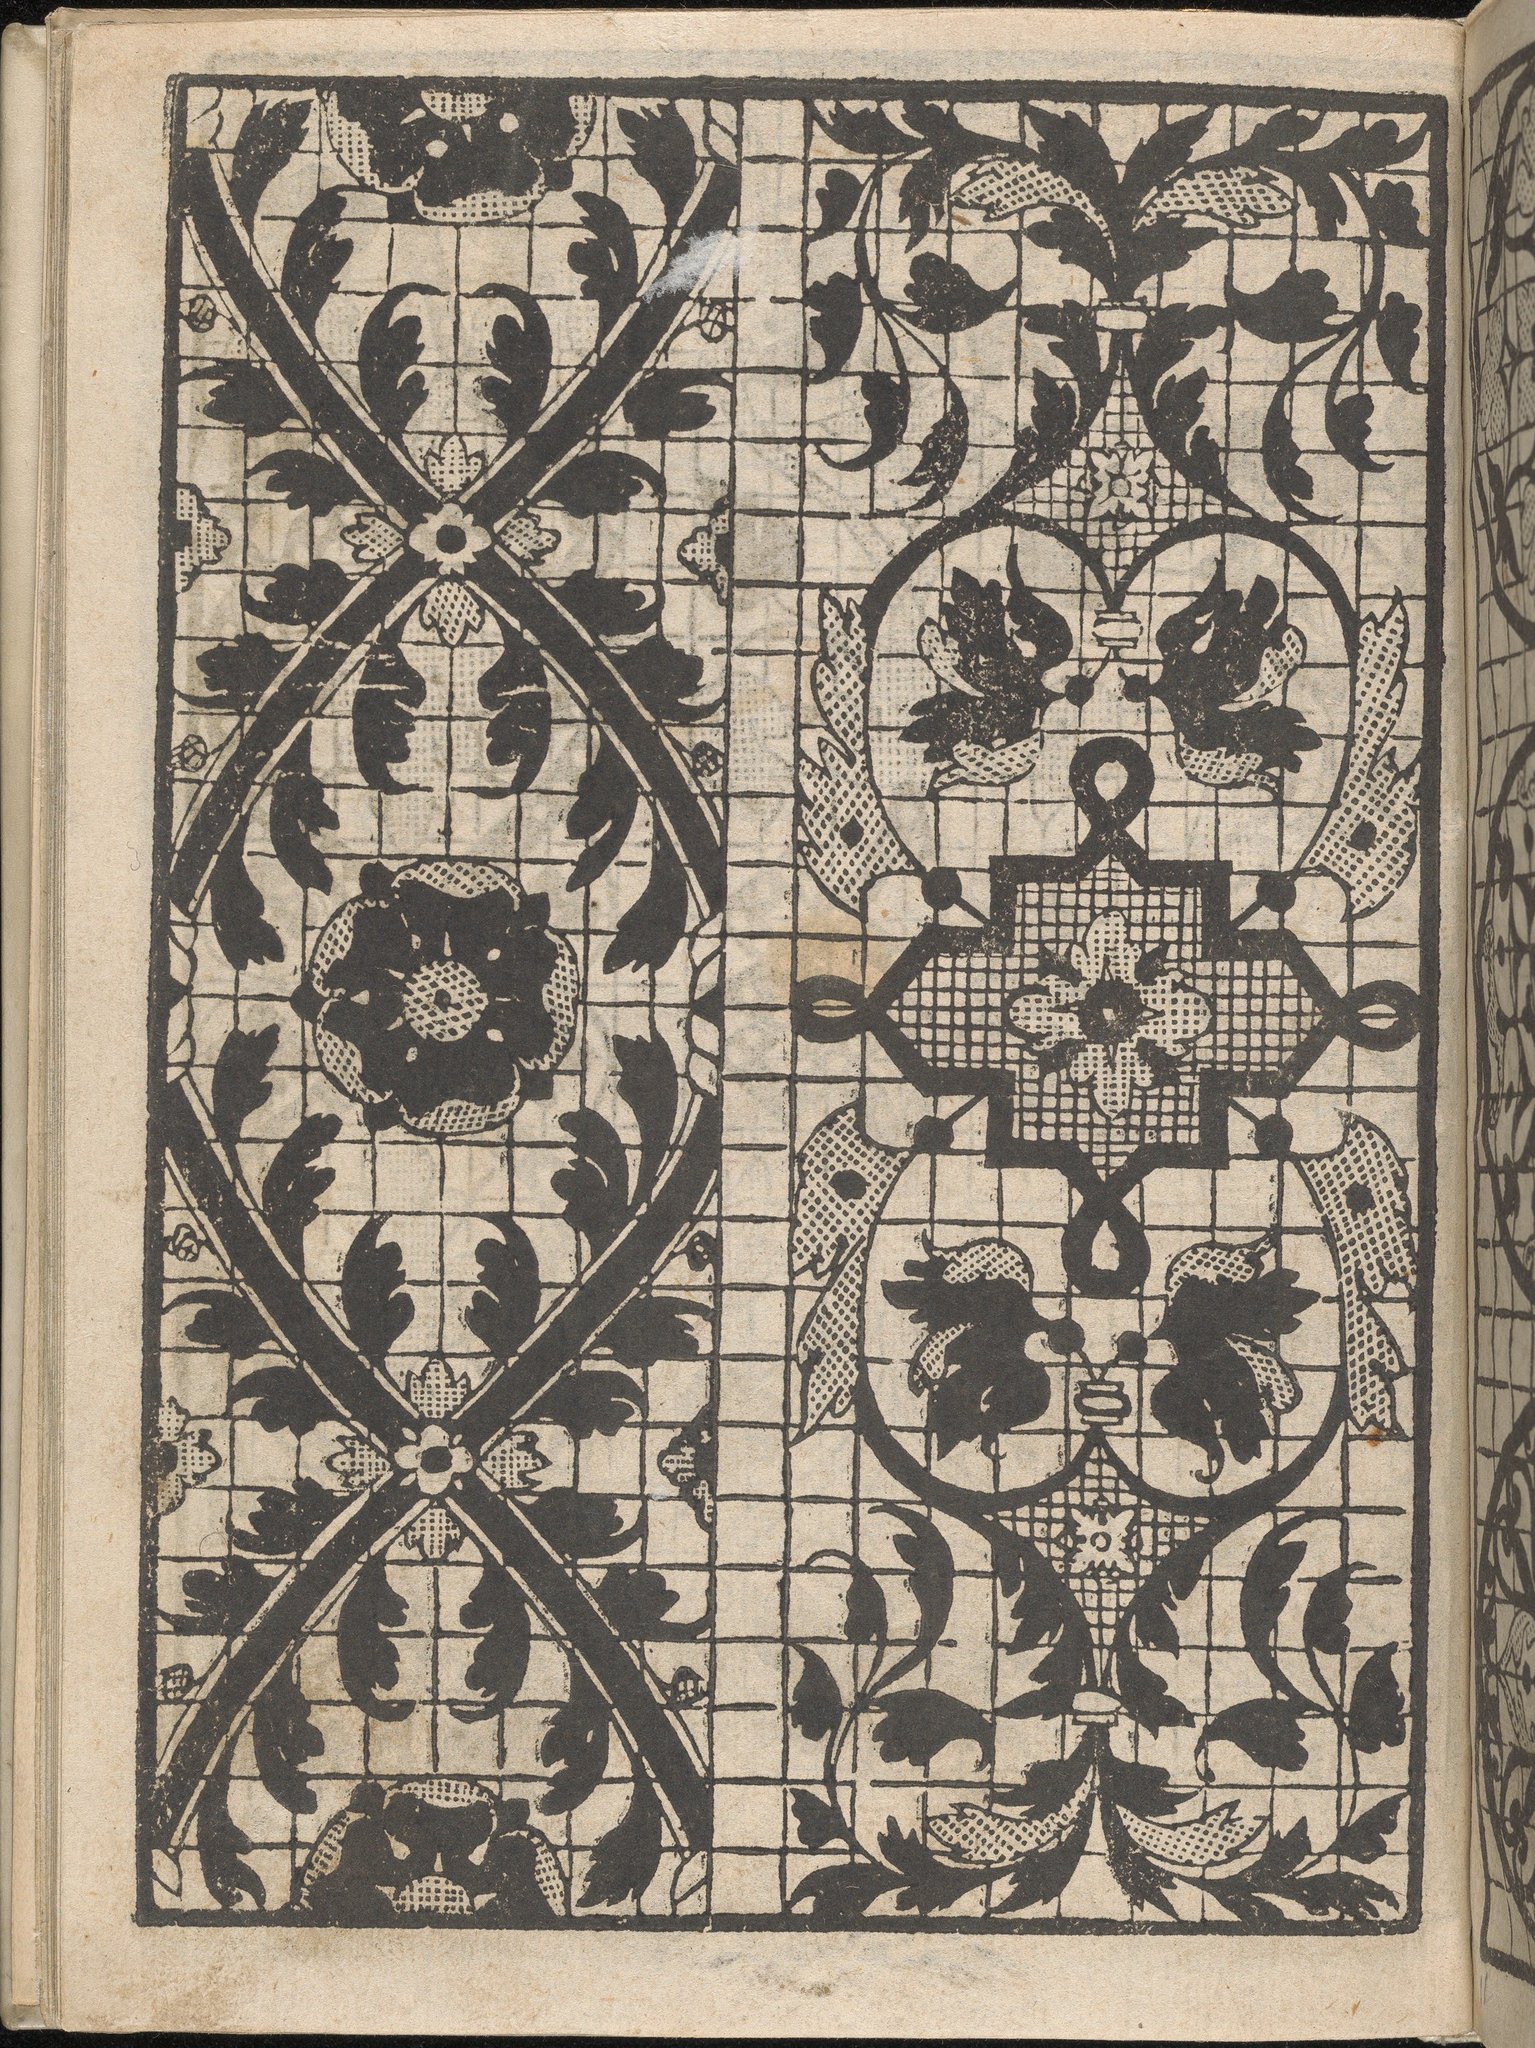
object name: book print ornament architecture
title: Splendore delle virtuose giovani, page 10 (verso)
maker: iseppo foresto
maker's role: designer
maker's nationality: italian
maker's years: 1520-1580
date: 1564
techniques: woodcut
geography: italy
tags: flowers